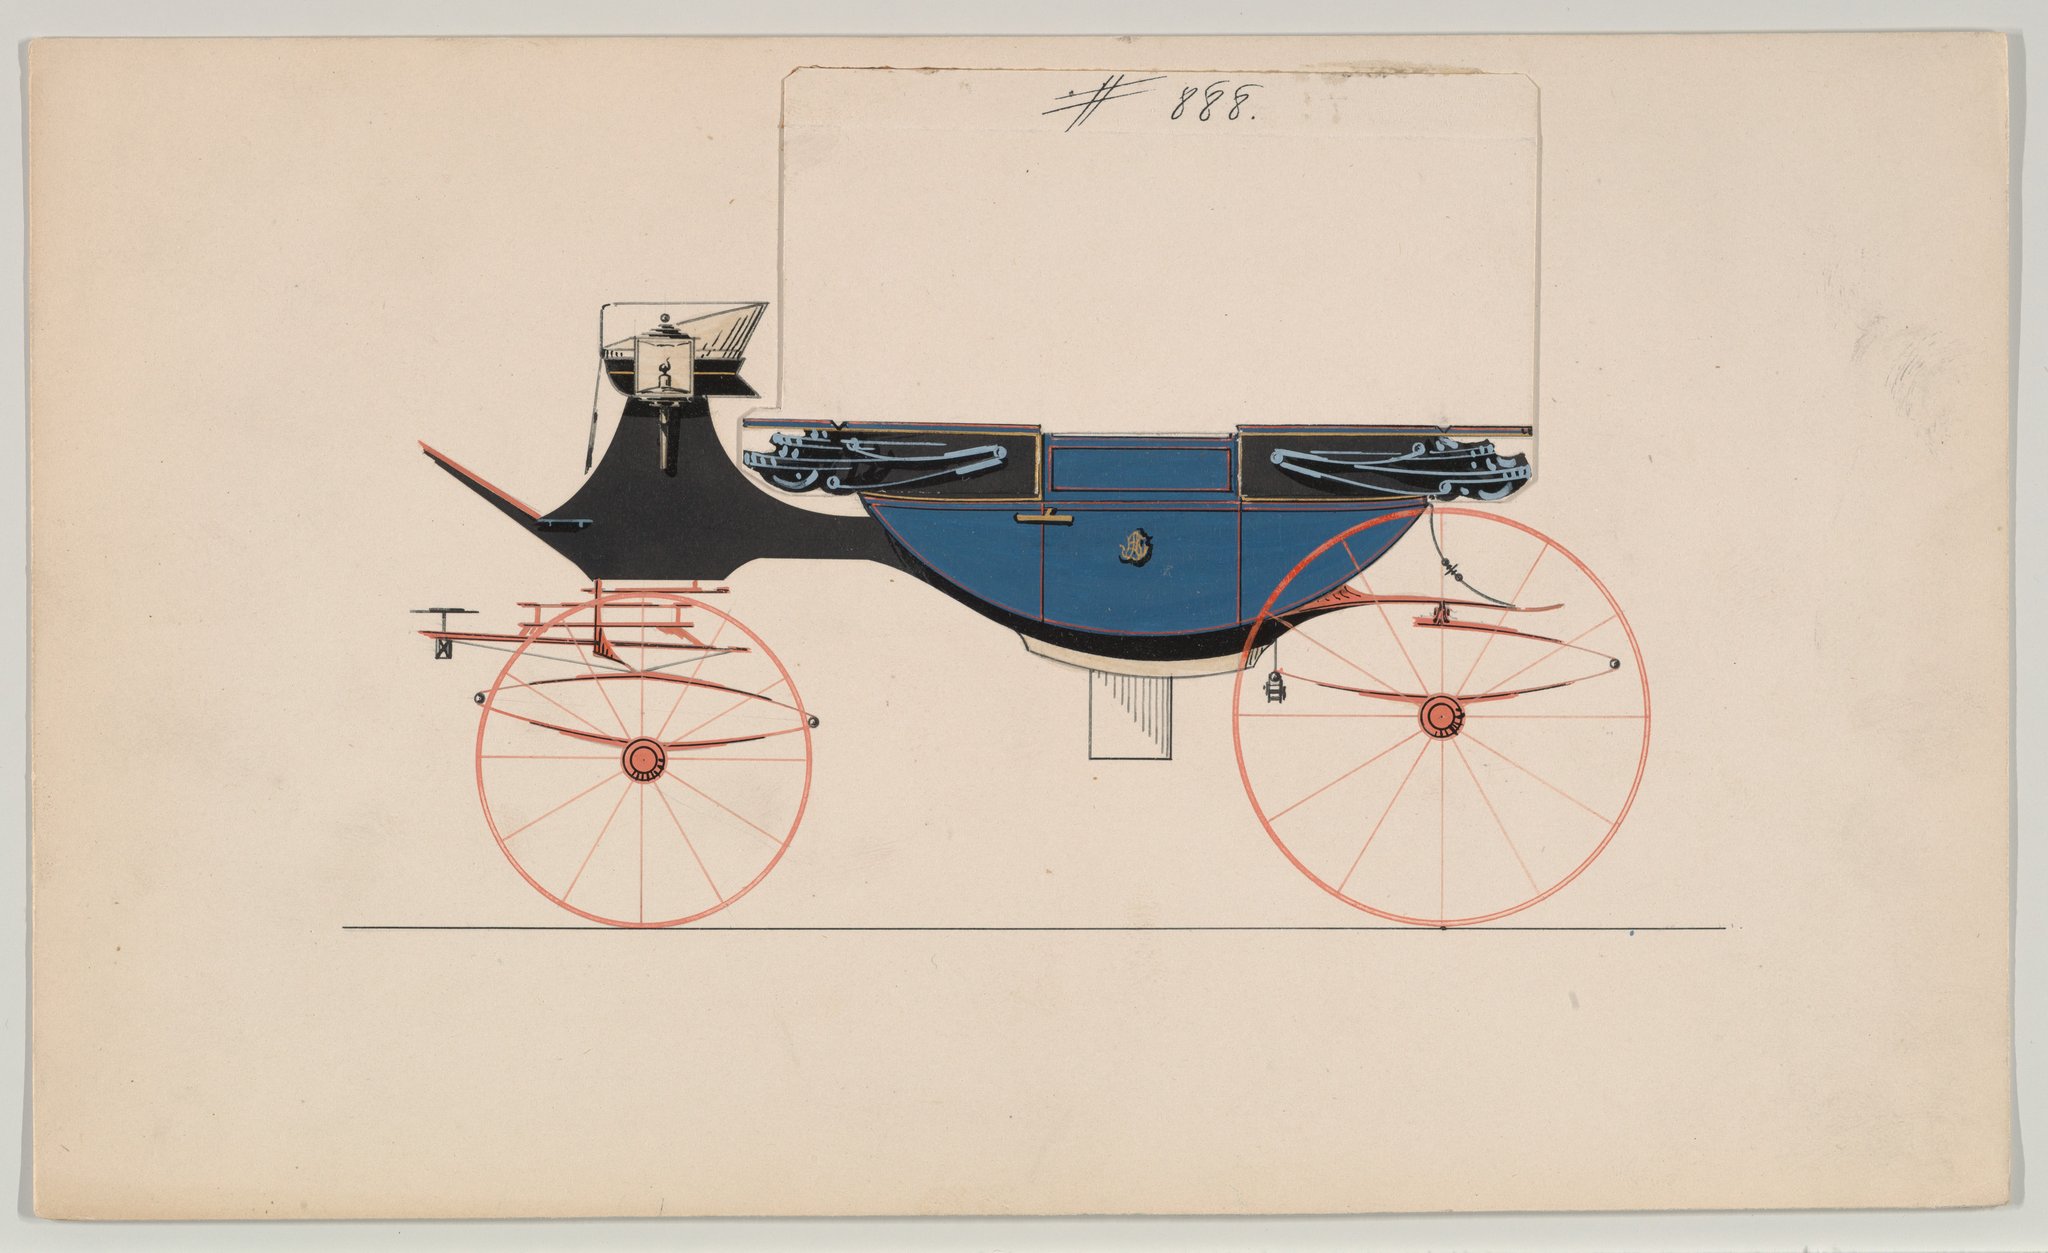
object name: drawing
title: Landau #888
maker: brewster & co.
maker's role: manufacturer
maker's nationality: american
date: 1859-1879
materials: gouache, gum arabic, ink, watercolor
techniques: pen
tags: carriages